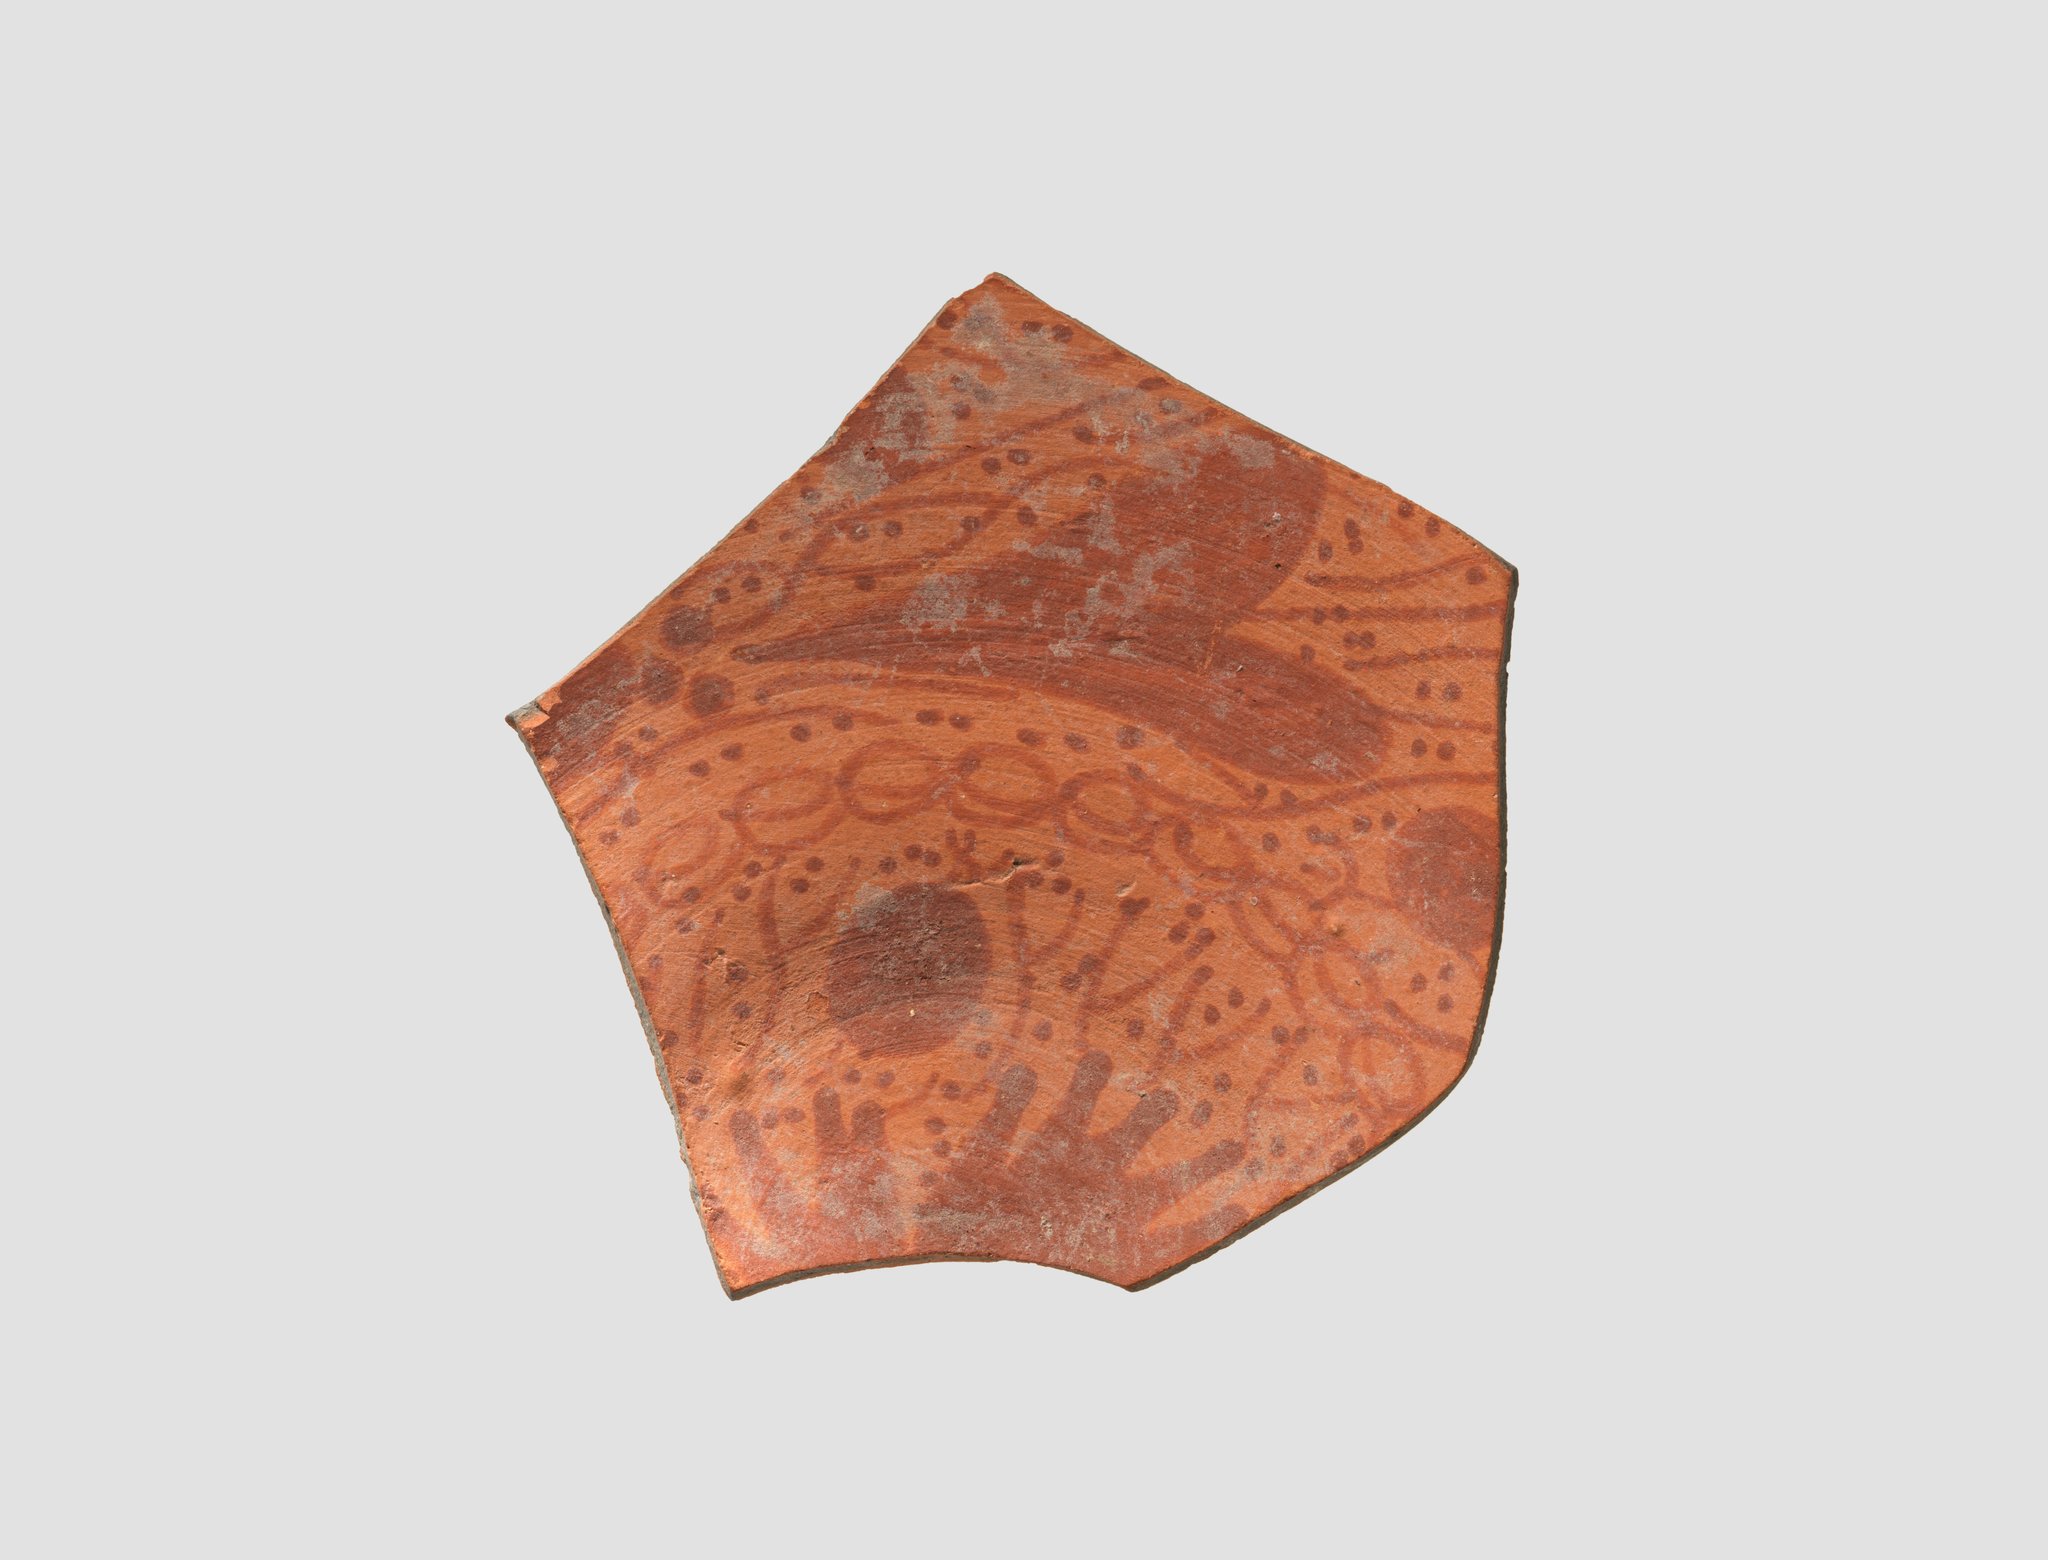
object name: sherd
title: Fragment of painted ware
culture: nabataean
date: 1-100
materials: ceramic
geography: levant